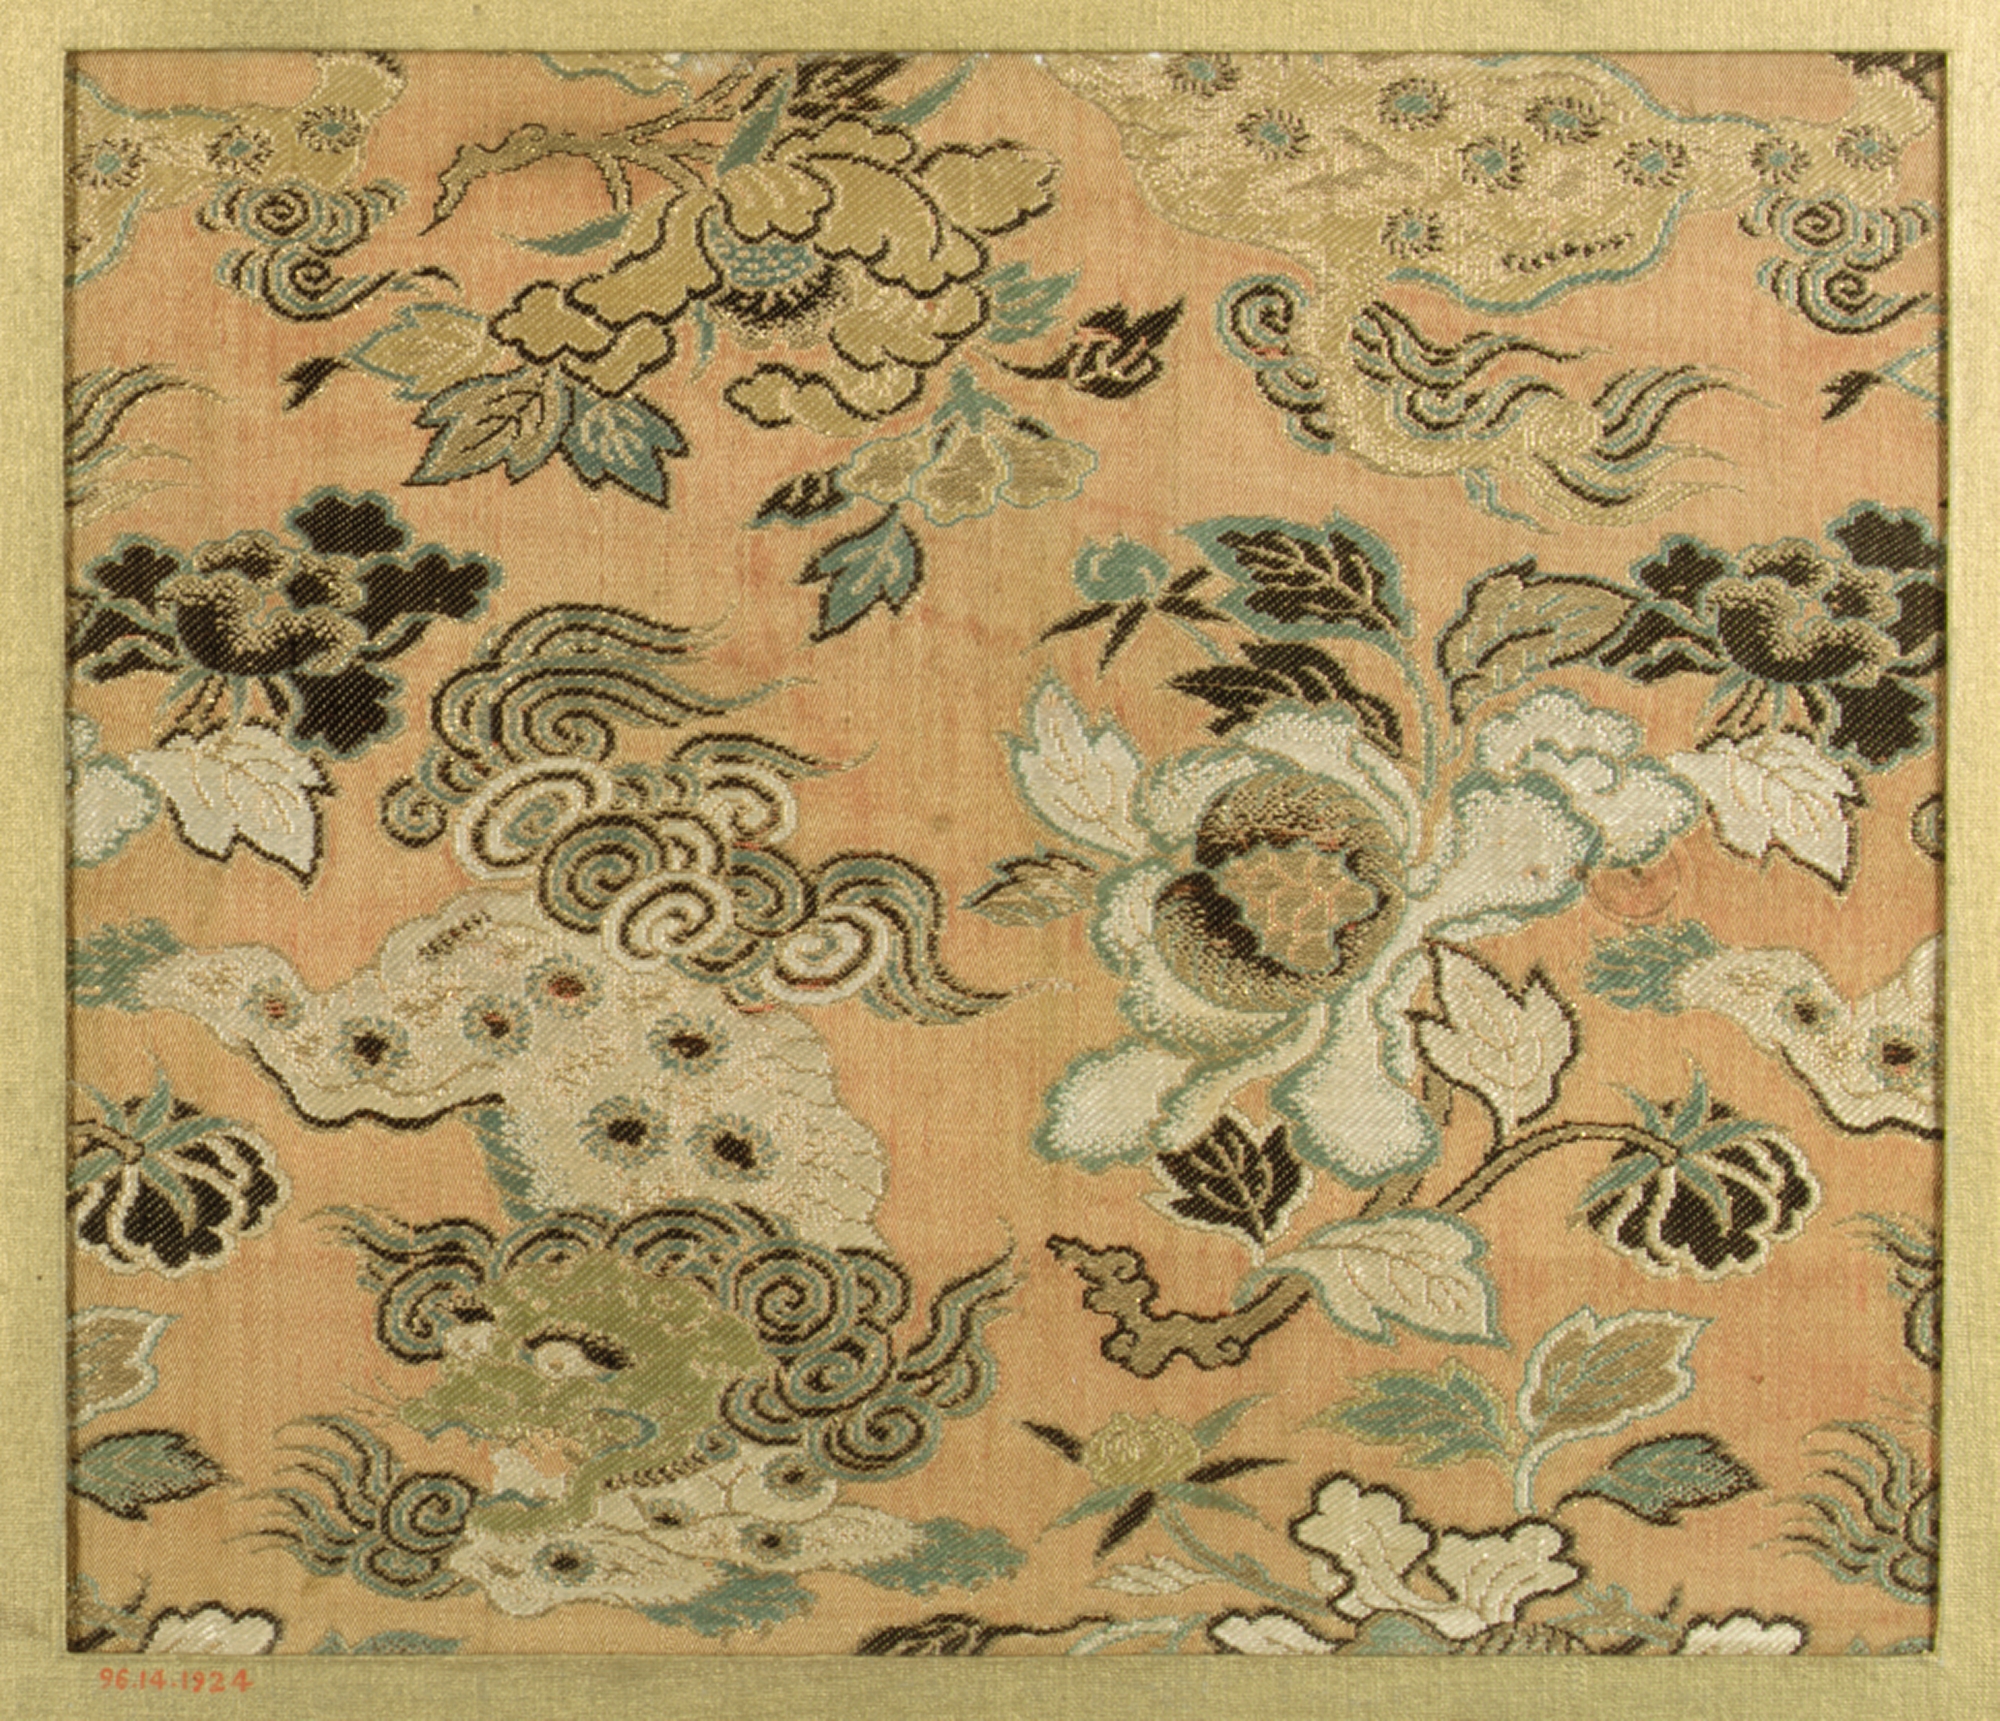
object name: piece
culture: japanese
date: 1701-1900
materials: silk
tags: animals,leaves